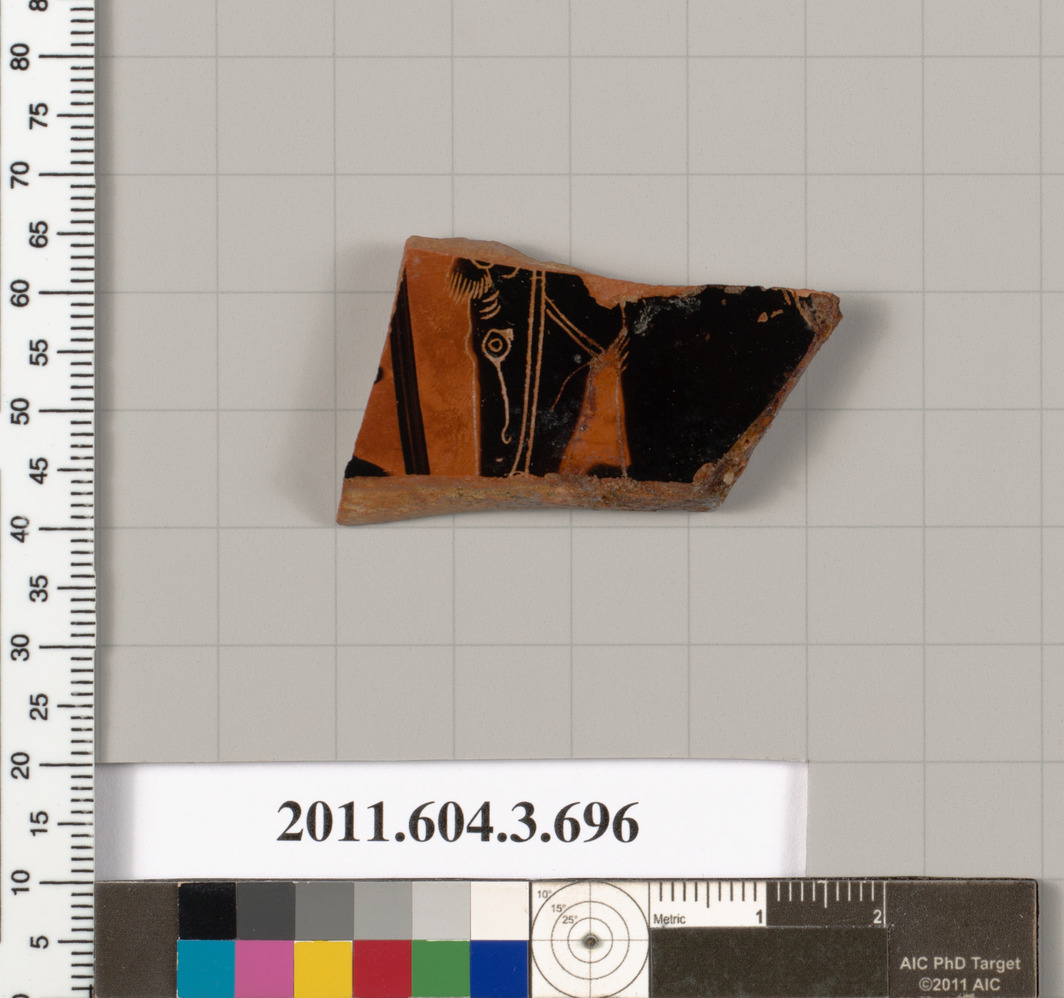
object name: hydria fragment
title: Terracotta fragment of a hydria (water jar)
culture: greek, attic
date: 550-526 BCE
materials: terracotta